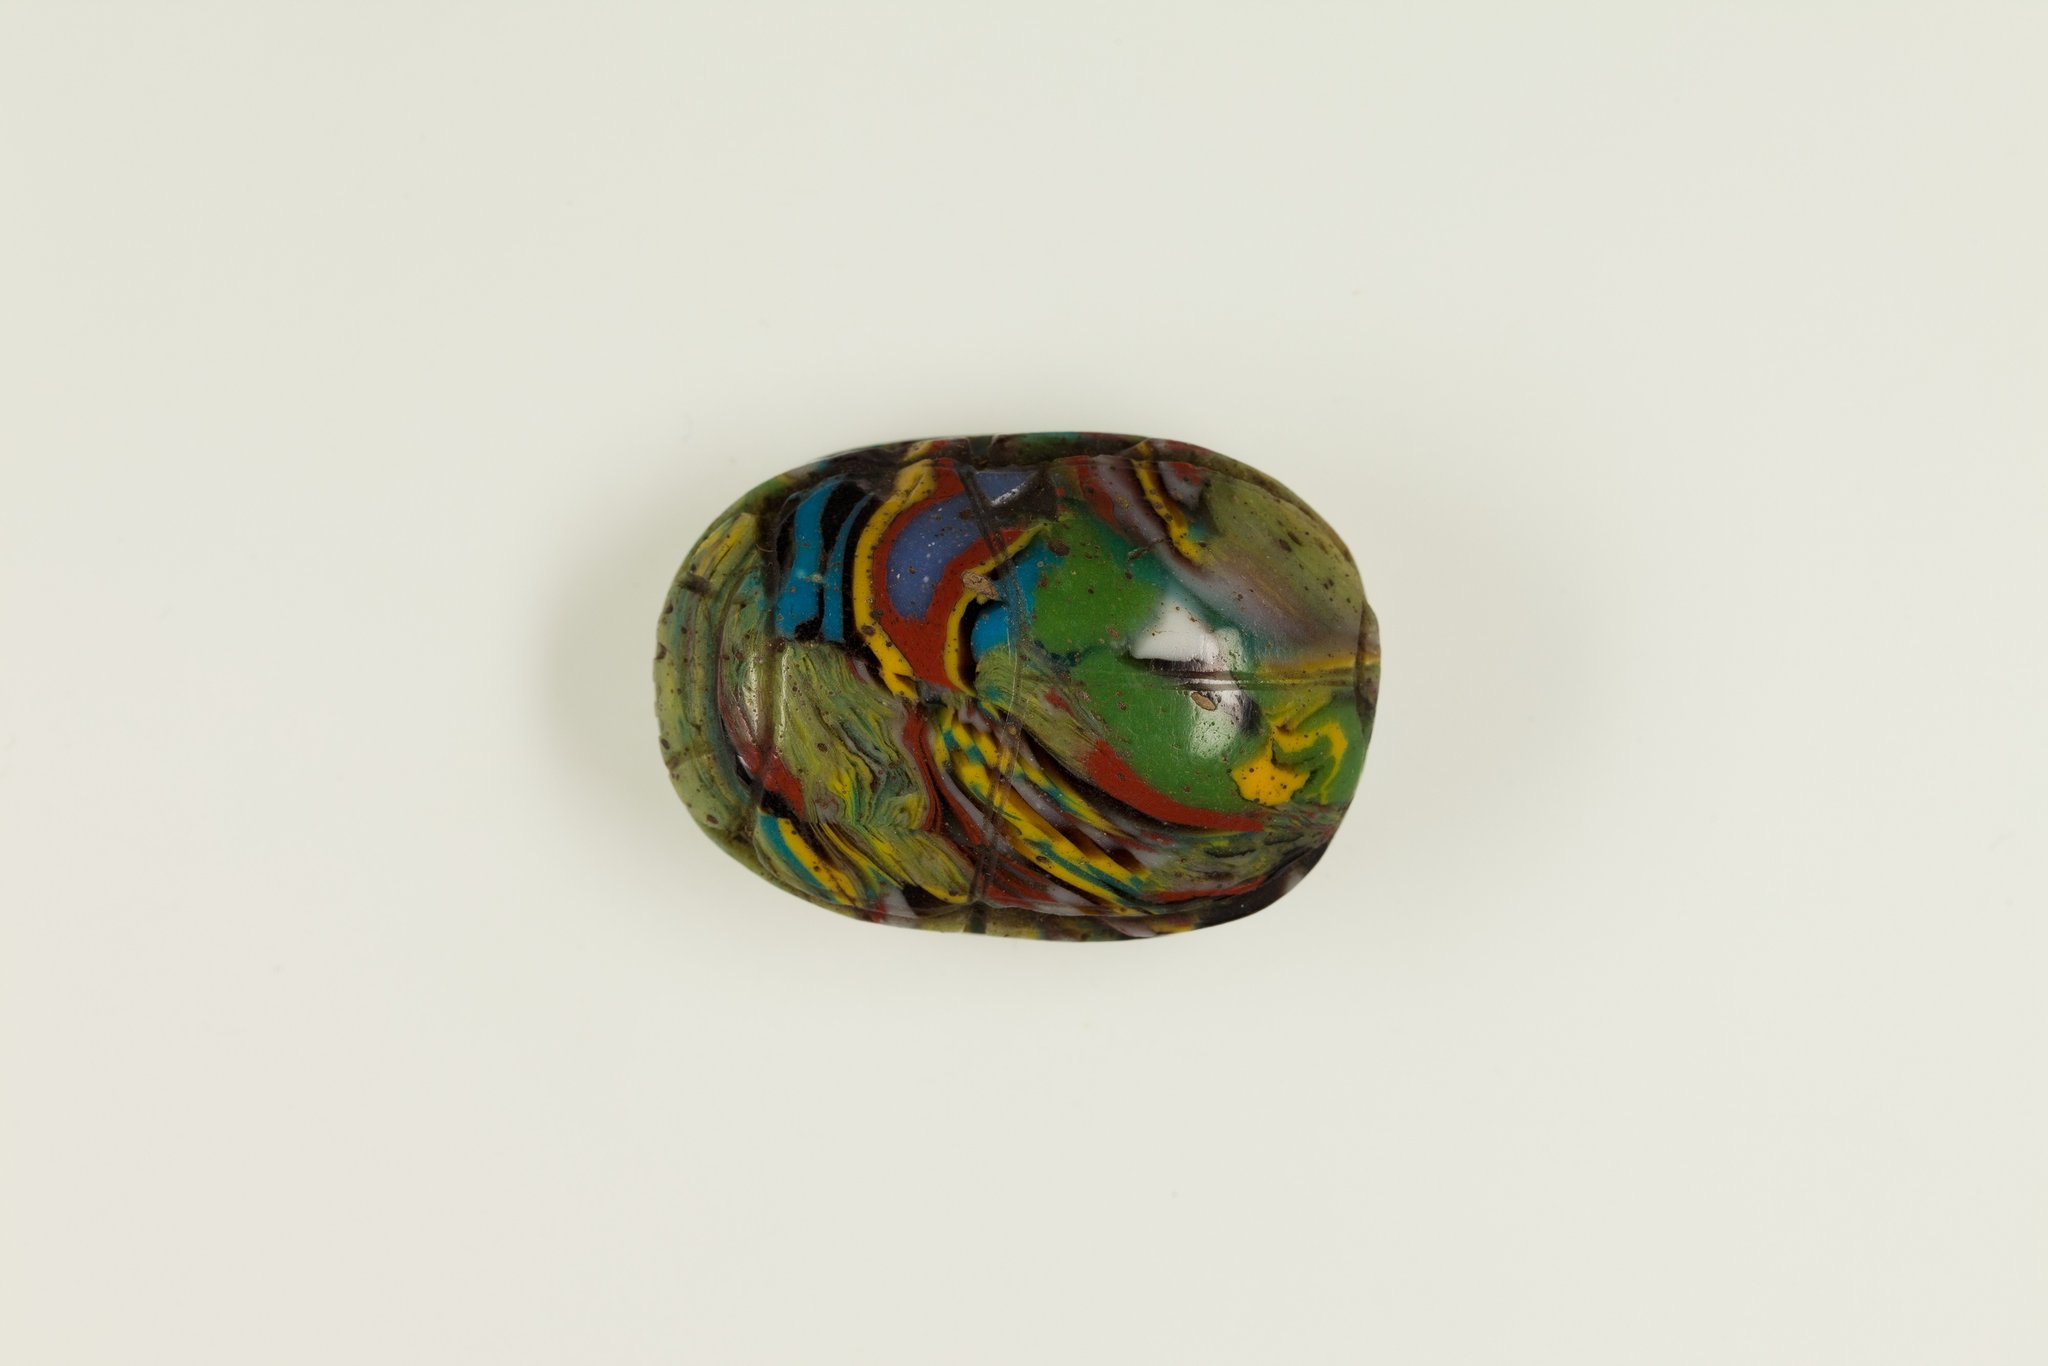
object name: scarab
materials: glass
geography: egypt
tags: scarabs